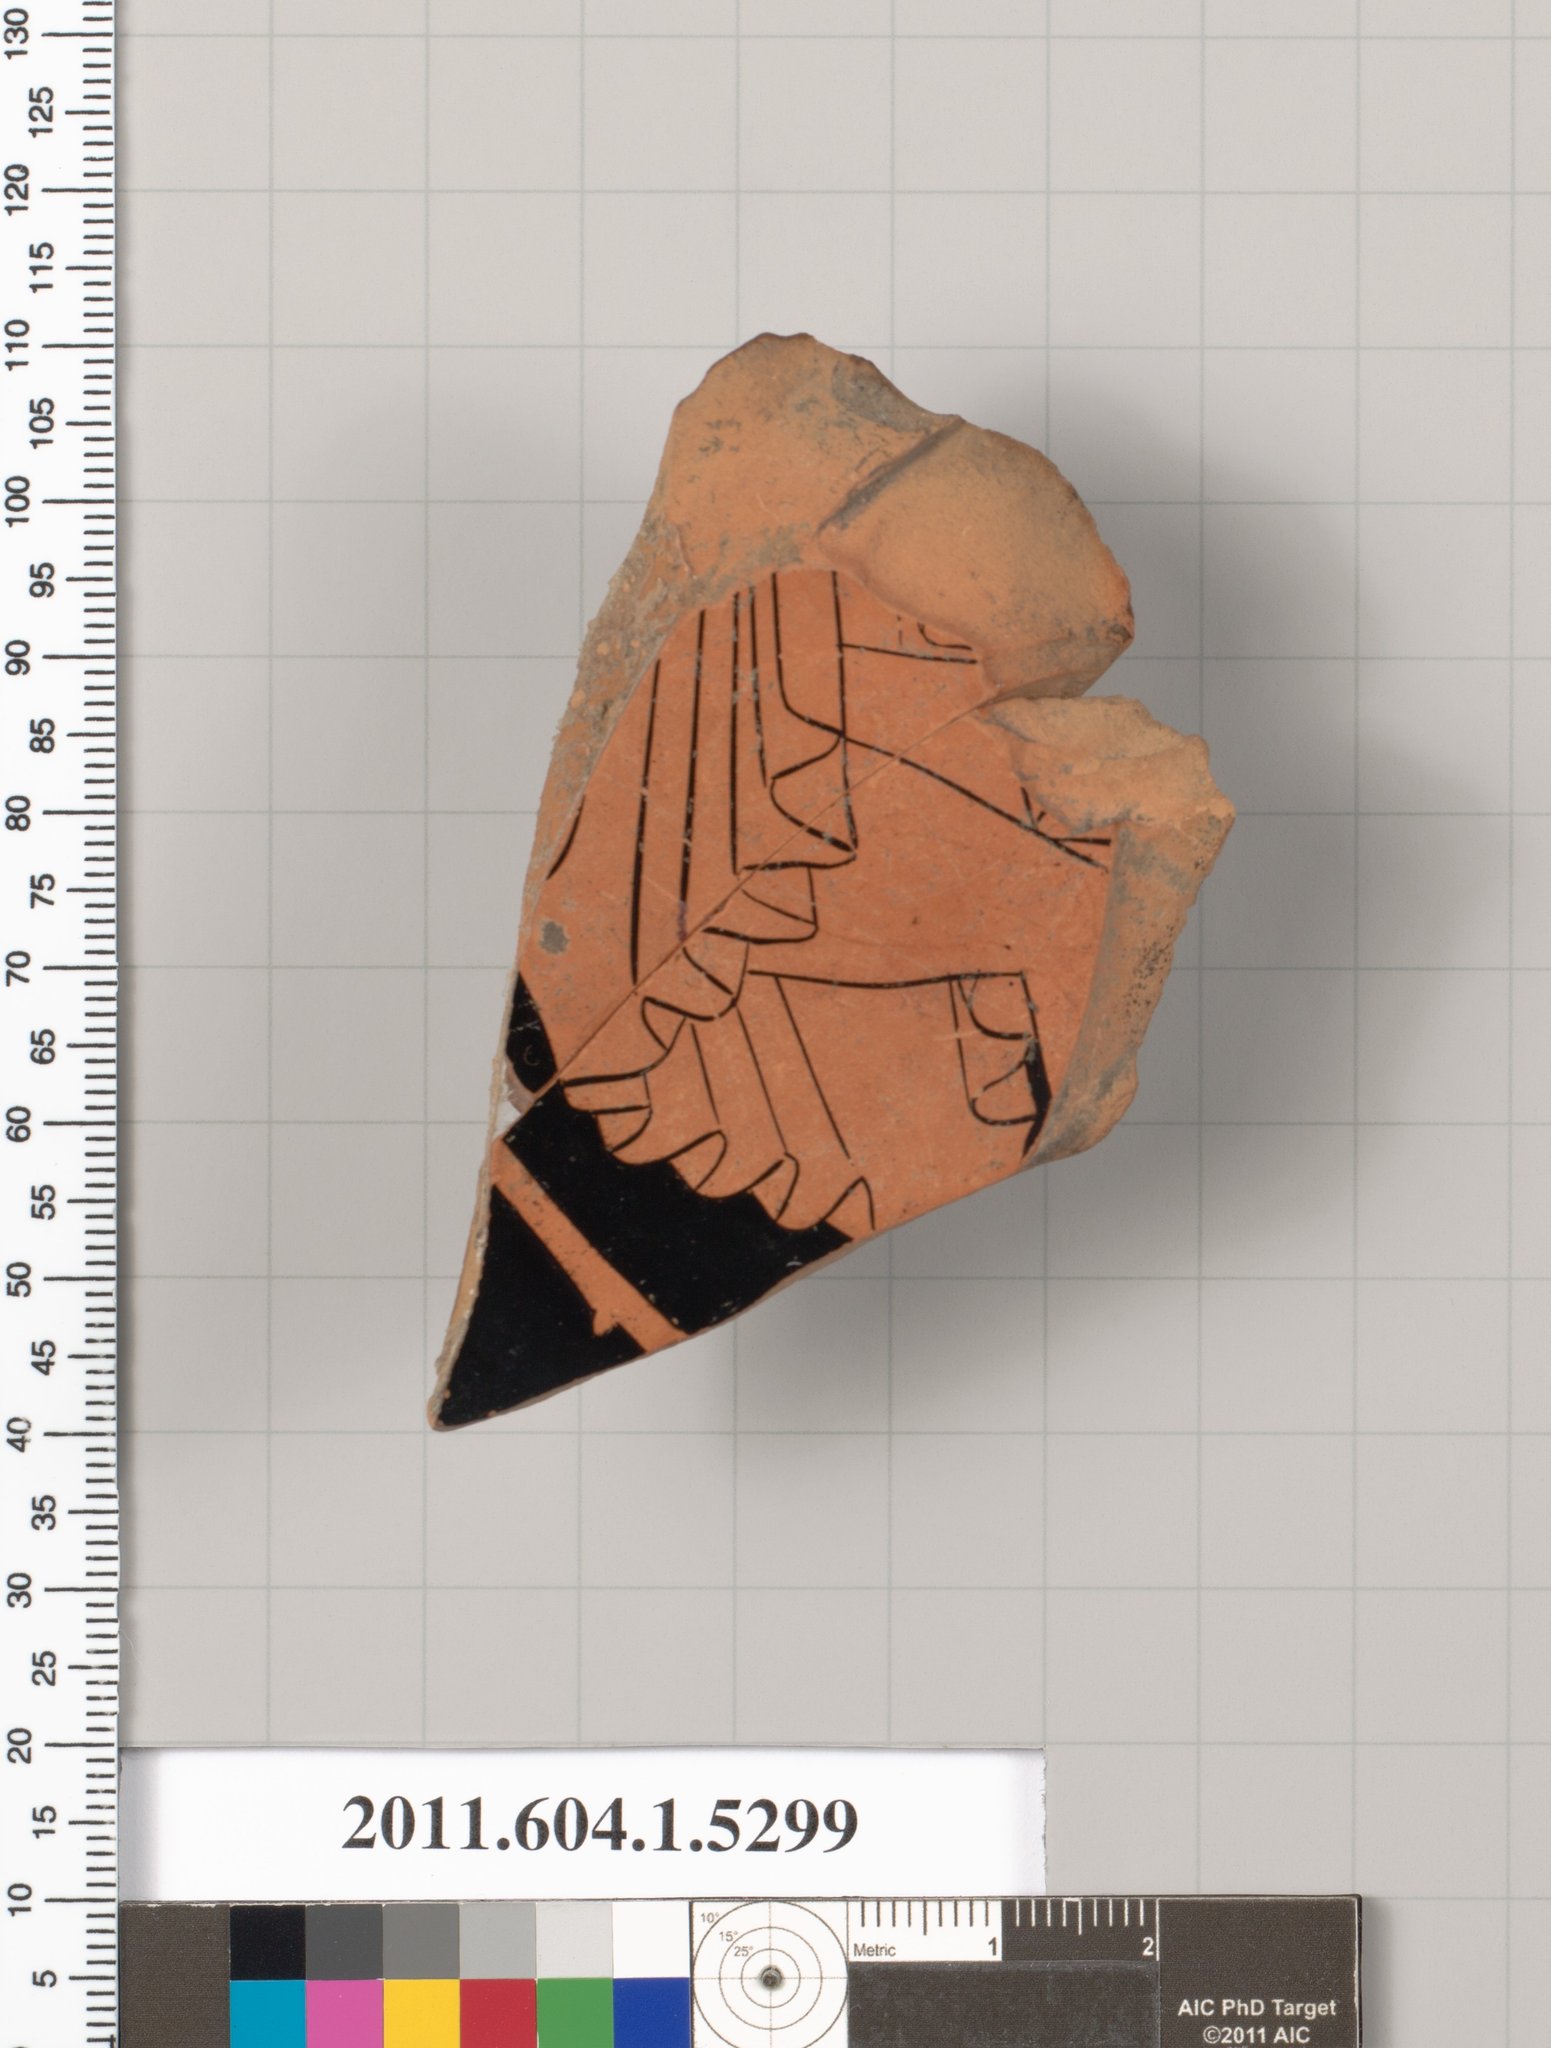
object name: kylix fragment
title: Terracotta fragment of a kylix (drinking cup)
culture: greek, attic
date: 490-480 BCE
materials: terracotta